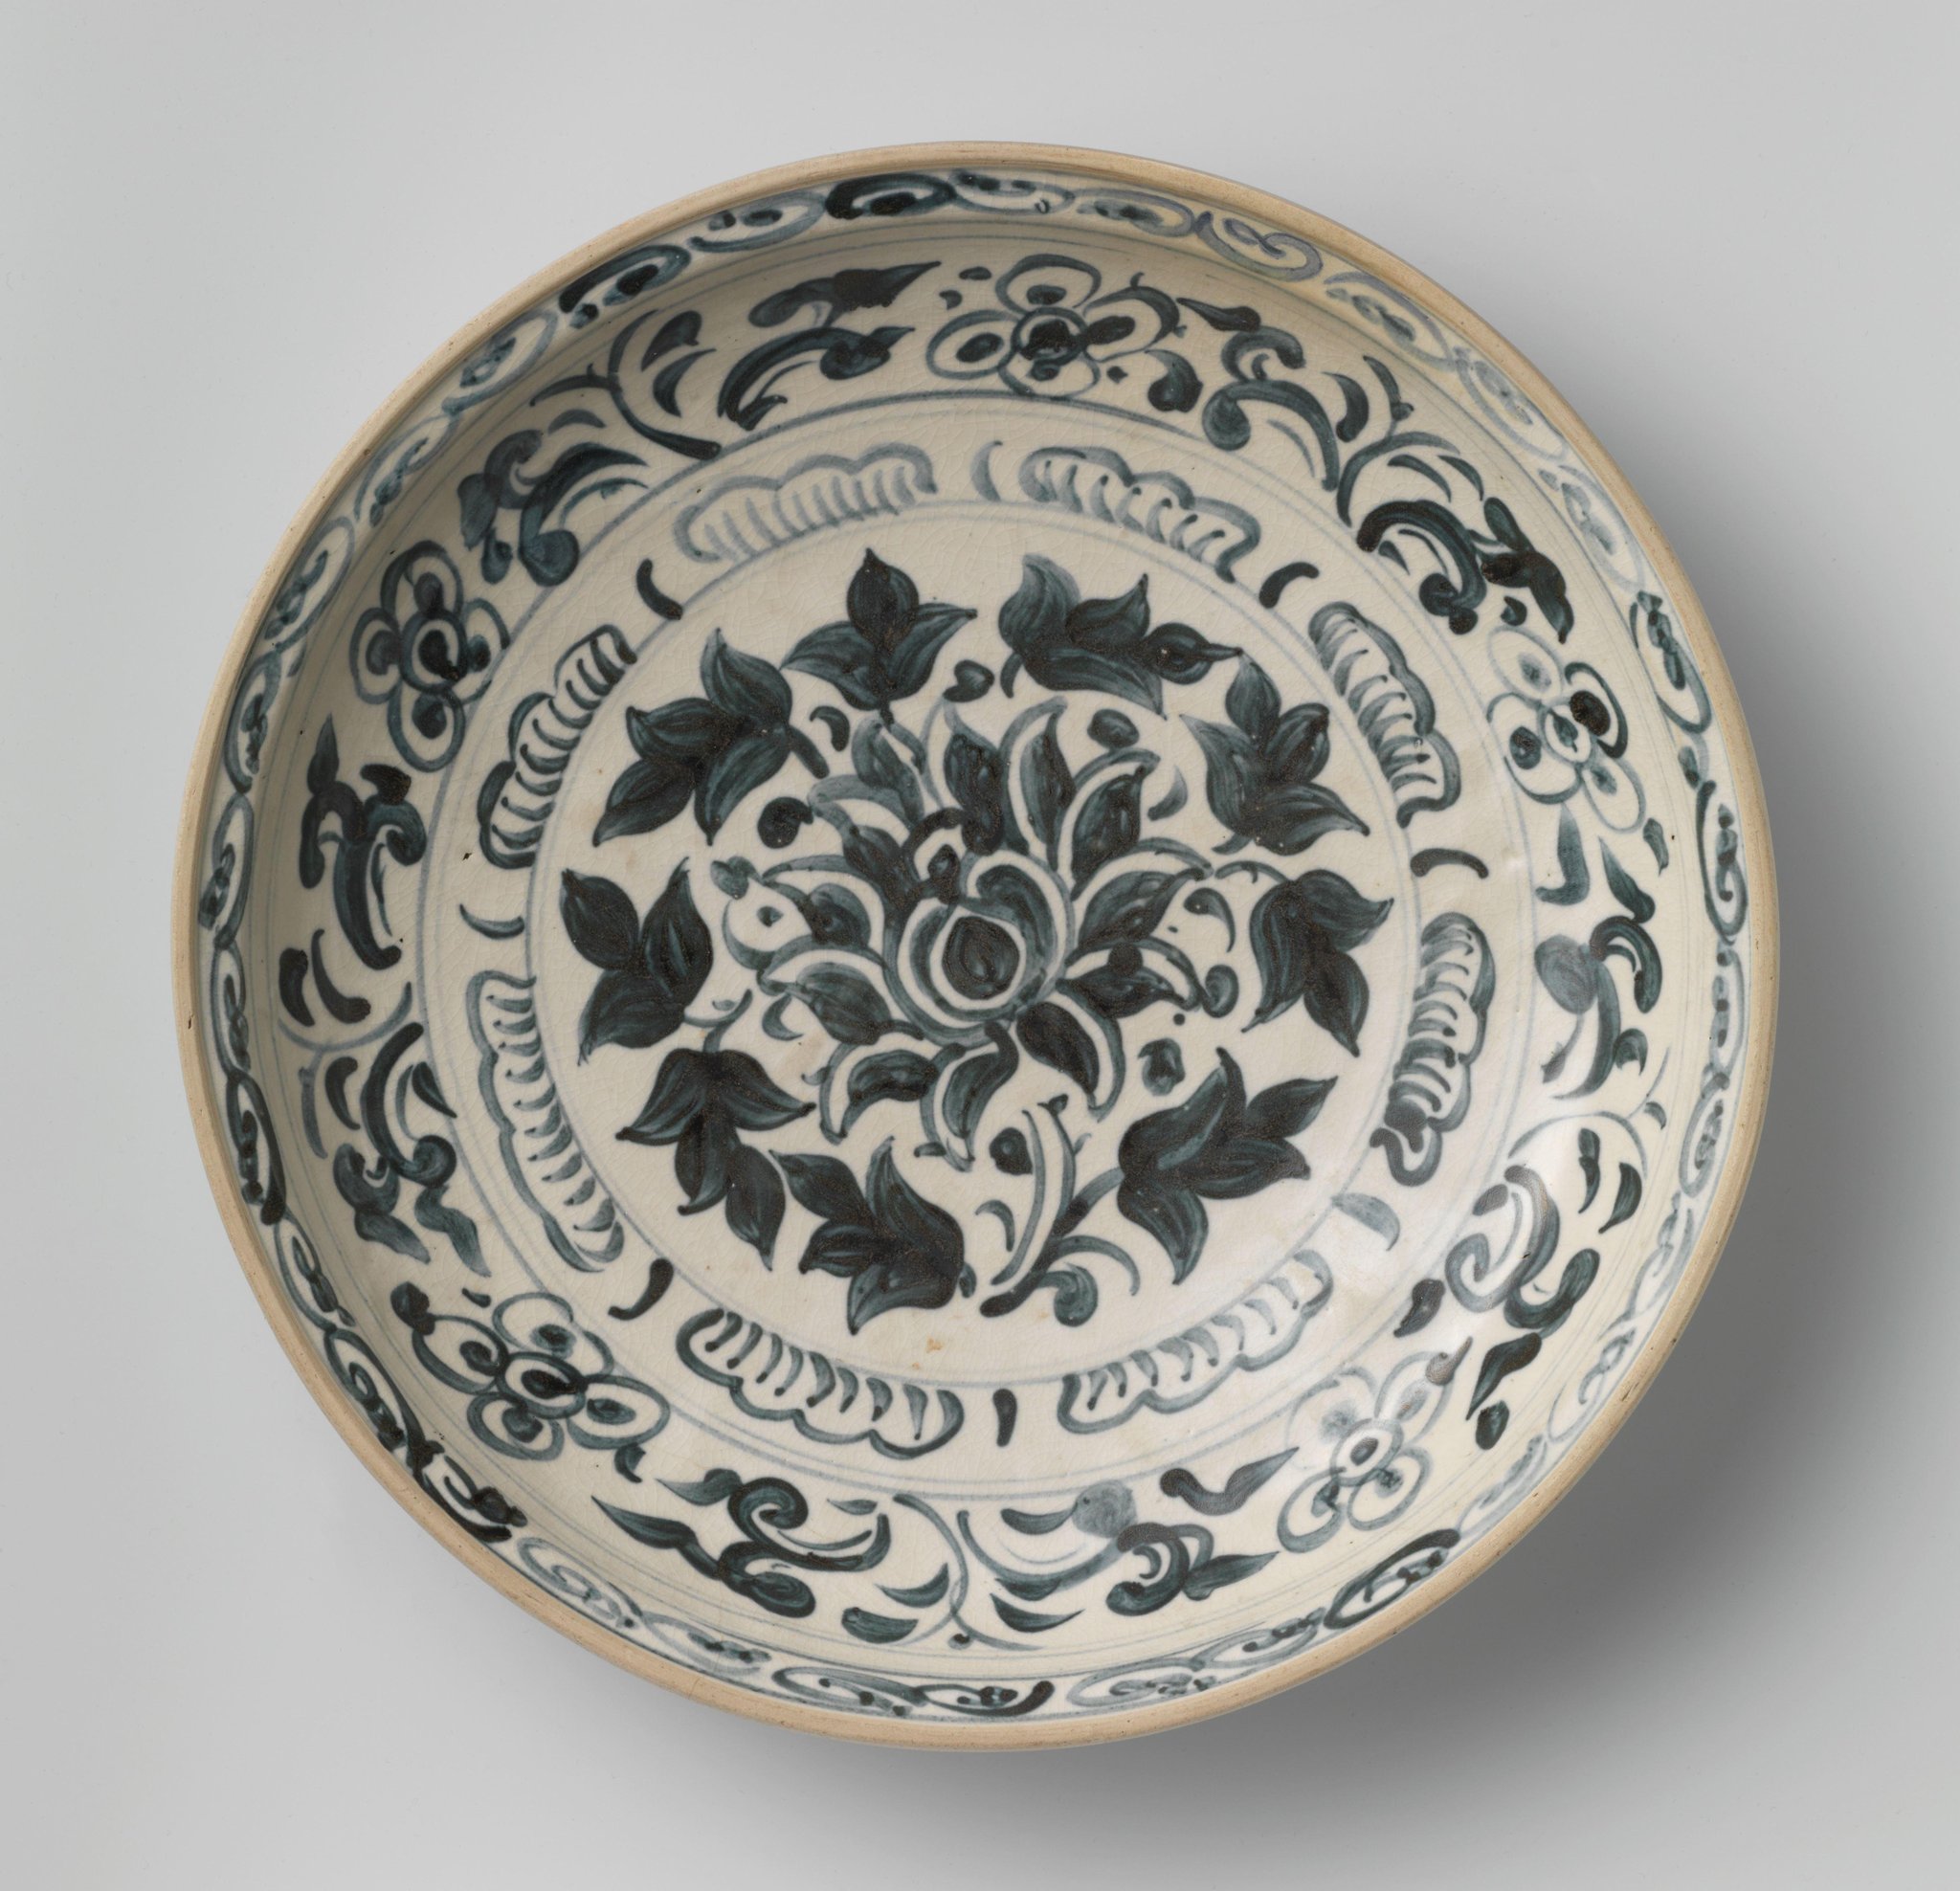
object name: platter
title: Dish with floral scrolls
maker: Anonymous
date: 1400-1499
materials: cobalt, glaze, paint, porcelain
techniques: firing, turning, vitrification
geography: vietnam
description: Dish. Vietnam. 16th century. Stoneware, blue underglaze decoration. With a peony in the centre, the decoration was painted with broad brush strokes. The free stroke and the grey-blue colour are typical Vietnamese features.